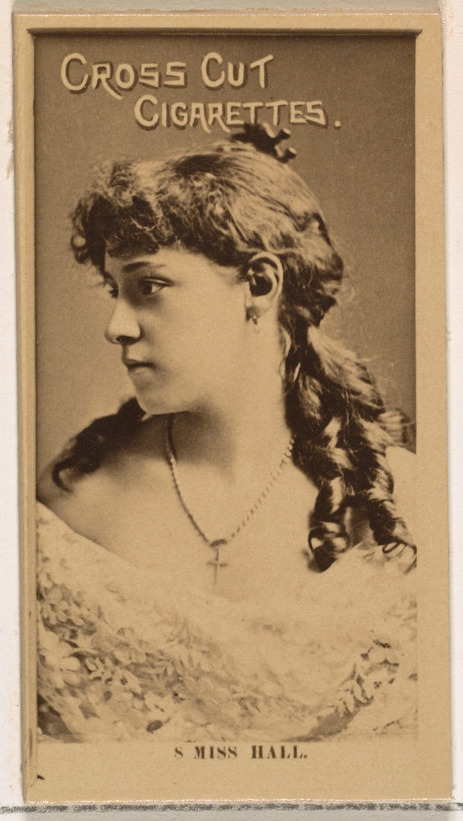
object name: print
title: Card Number 8, Miss Hall, from the Actors and Actresses series (N145-2) issued by Duke Sons & Co. to promote Cross Cut Cigarettes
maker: w. duke, sons & co.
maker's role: publisher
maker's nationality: american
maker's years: 1870-1920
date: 1880-1889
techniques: albumen silver print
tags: women,actresses